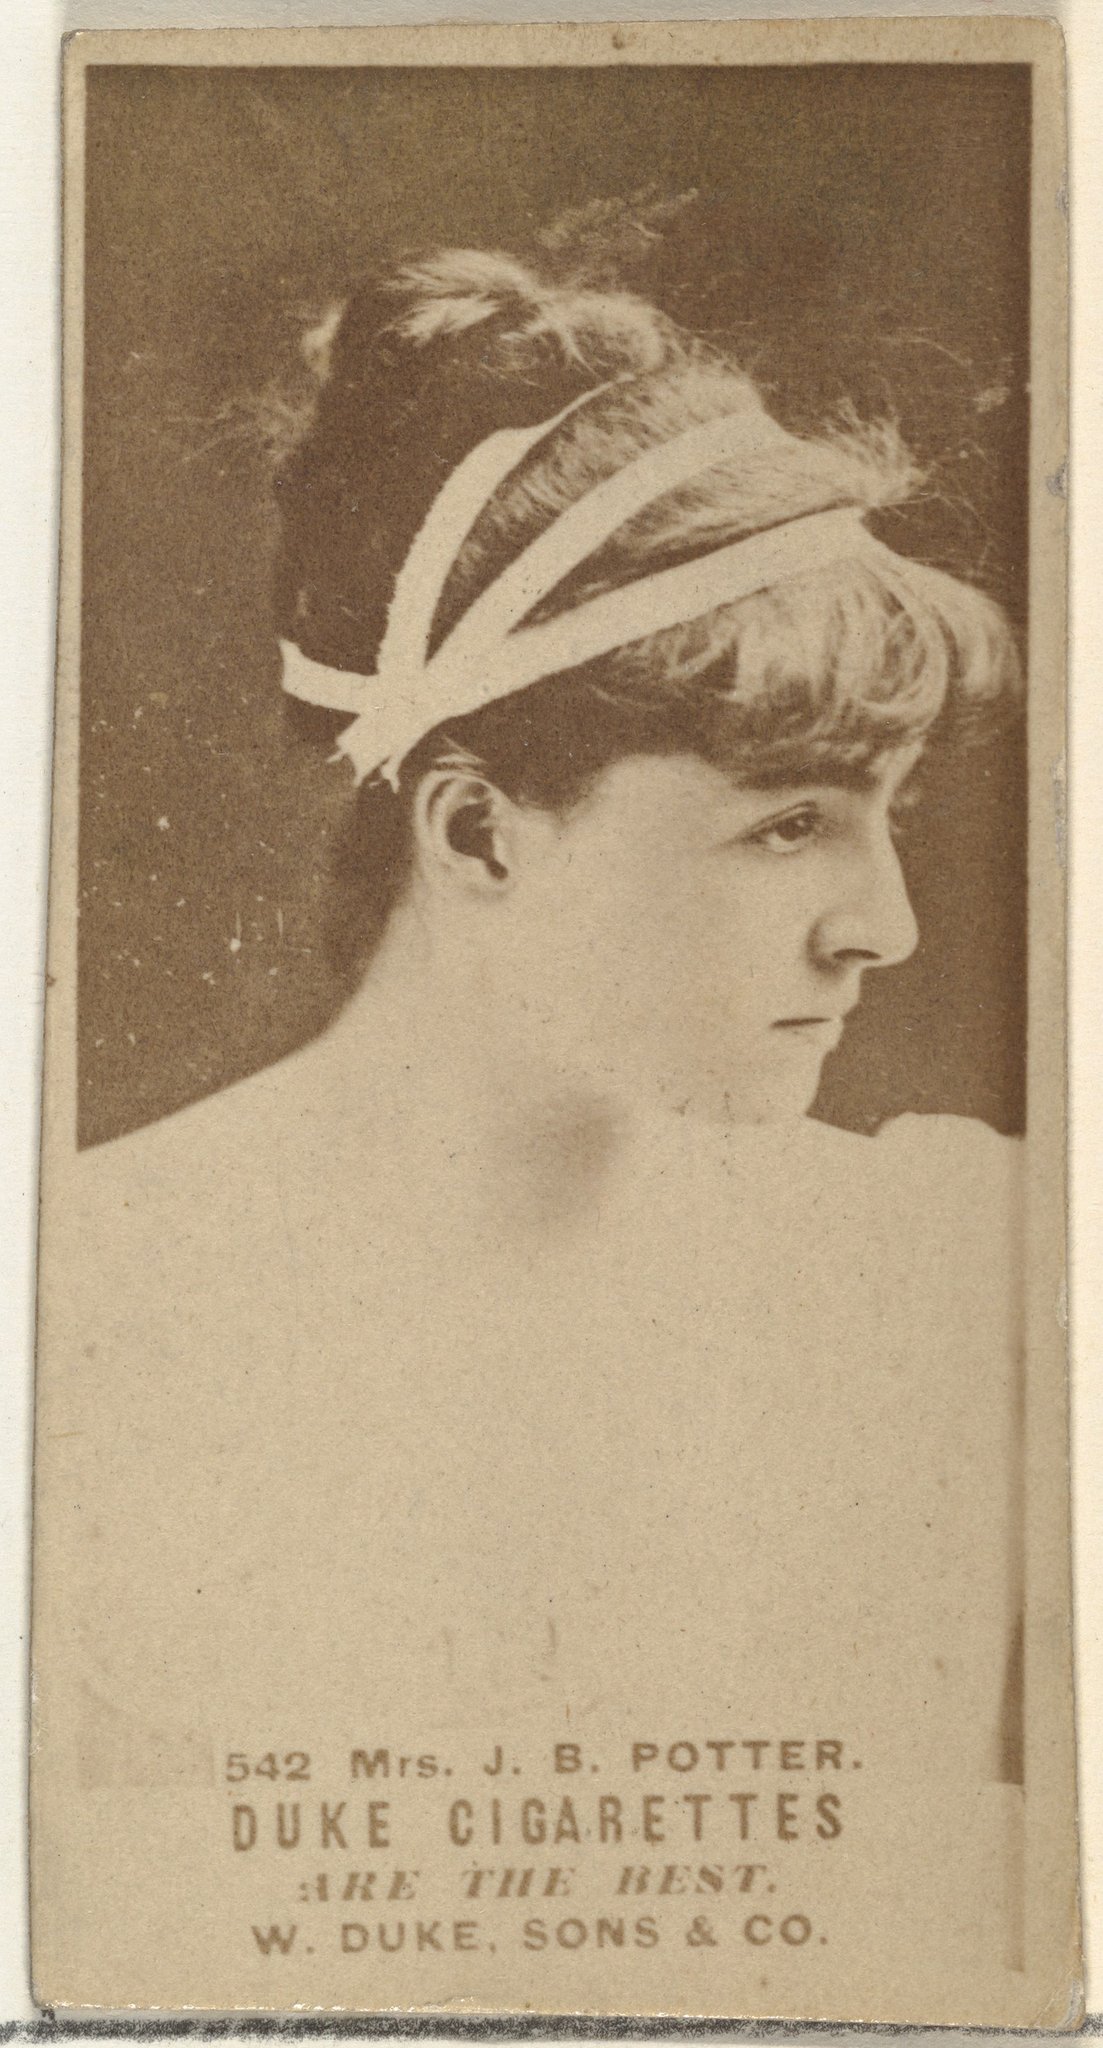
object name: photograph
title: Card Number 542, Mrs. James Brown Potter, from the Actors and Actresses series (N145-7) issued by Duke Sons & Co. to promote Duke Cigarettes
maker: w. duke, sons & co.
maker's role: publisher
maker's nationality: american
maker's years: 1870-1920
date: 1880-1889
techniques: albumen silver print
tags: women,actresses